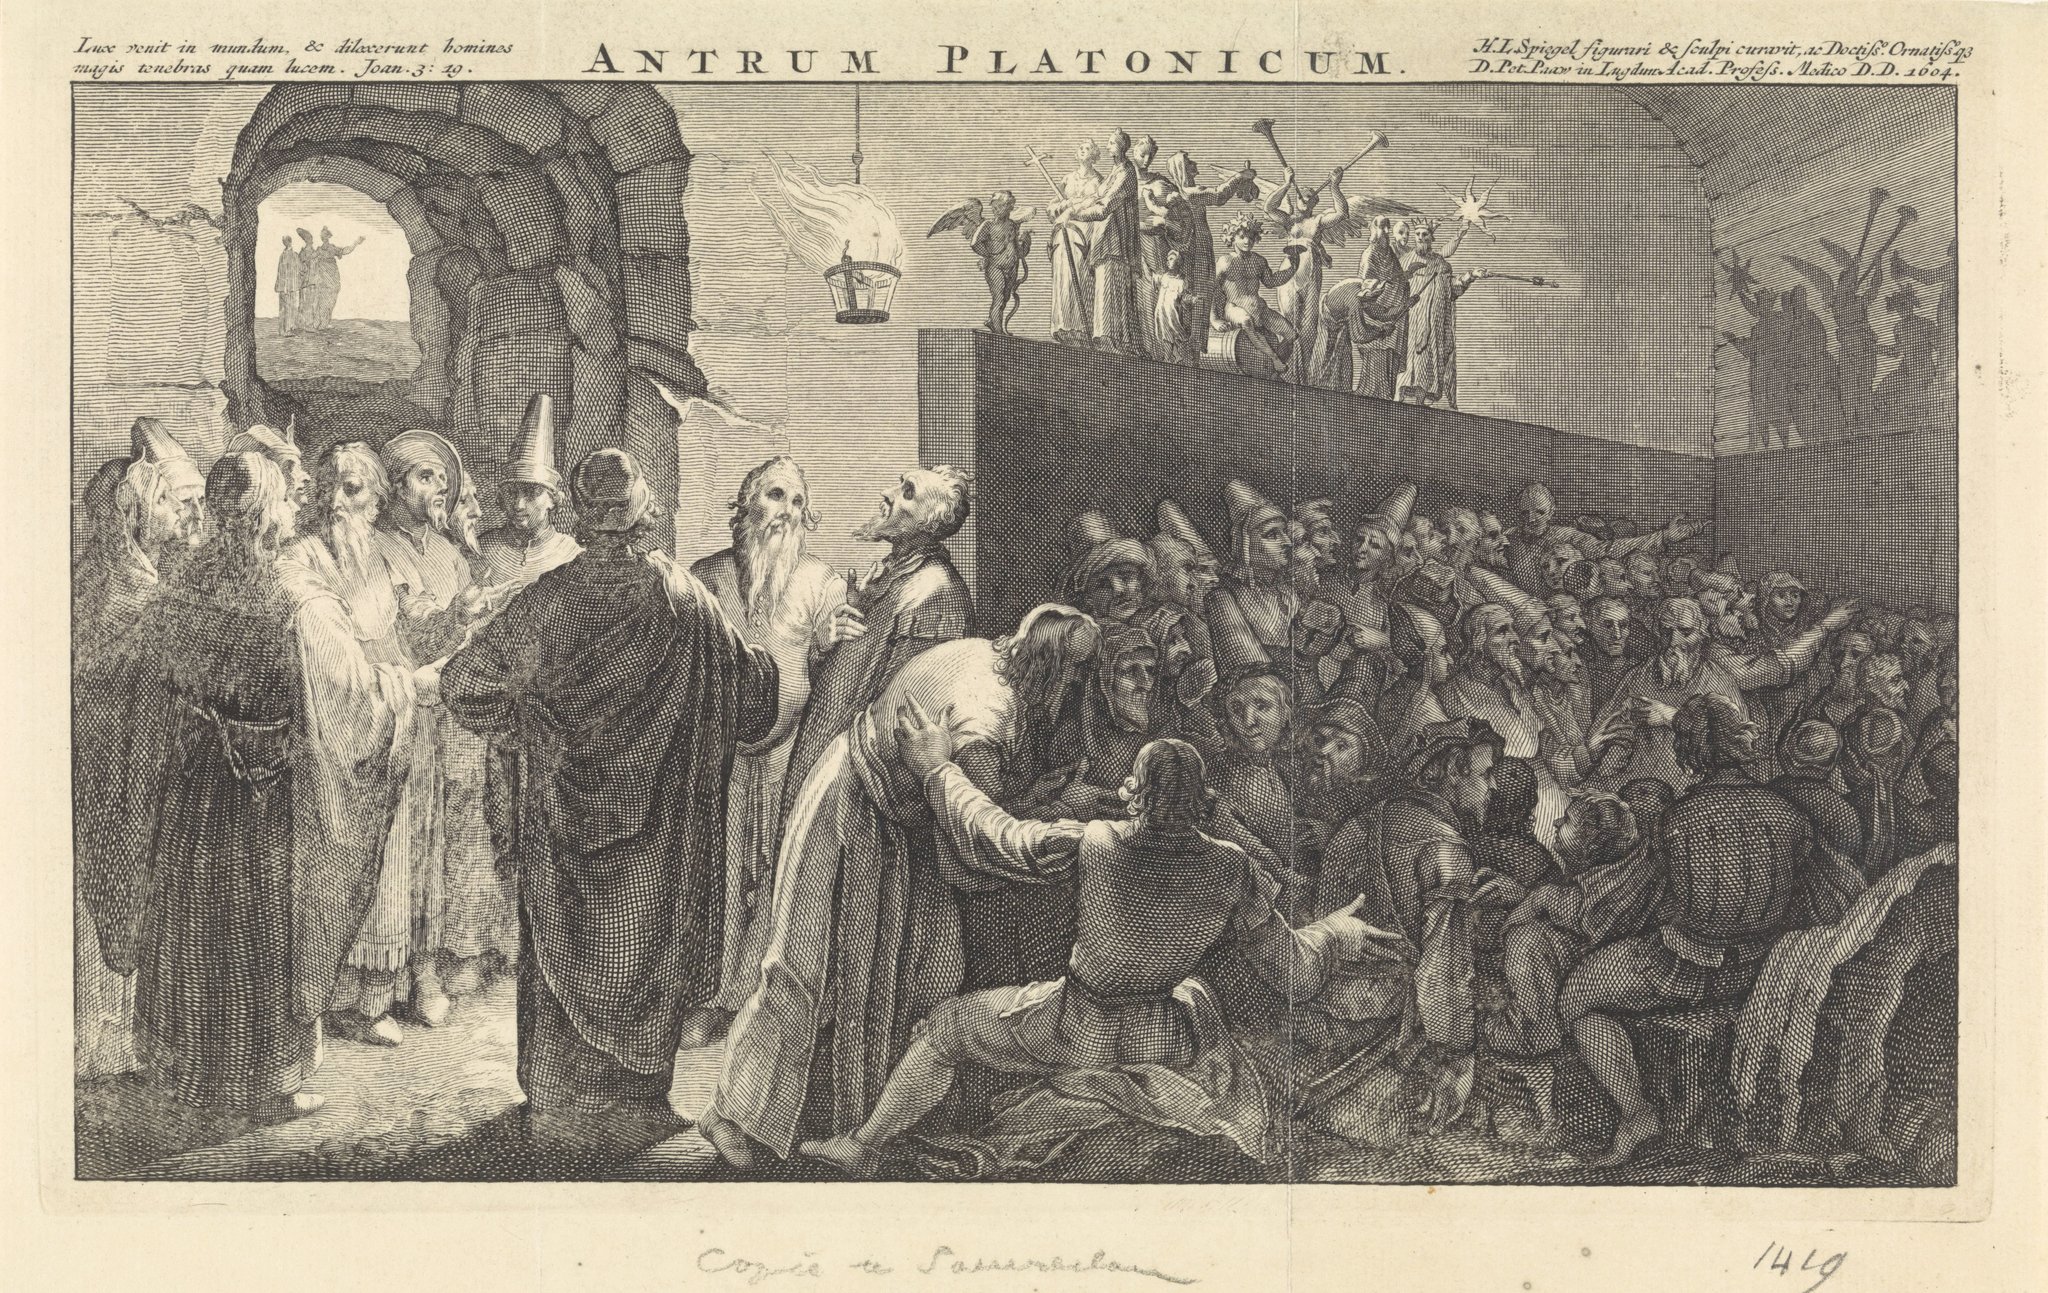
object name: print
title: Grot van Plato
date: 1604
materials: paper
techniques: engraving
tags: amsterdam, hendrick laurensz. spieghel, plato's cave, 'antrum platonicum'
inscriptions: collector's mark: Lugt 2228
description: De grot van Plato, afgebeeld als een kamer van het hart. De grot wordt door een grote muur in tweeën gedeeld. Op de muur staan allerlei personificaties (Liefde, Hoop, Geloof, Gierigheid, Drankzucht, Faam, enz.). Een vuurpot achter deze personificaties werpt hun schaduwen op de grotwand. Op de voorgrond rechts zit een grote groep mensen, van verschillende standen en religies. Ze zijn aan het discussiëren, maar kijken alleen naar de schaduwen van de personificaties. Ze bevinden zich in de schaduw van de muur. Links op de voorgrond van de grot bevindt een groep geleerden zich in het licht. Ook zij debatteren, maar kijken naar de personificaties en de vuurpot. Twee geleerden trachten de mensen achter de wand te overtuigen in het licht te stappen. Op de achtergrond een smalle doorgang naar de wereld buiten de grot. Slechts drie mannen hebben de doorgang opgemerkt en doorlopen. Zij bevinden zich in de buitenlucht. De prent heeft een Latijns opschrift met een Bijbelcitaat en een opdracht.